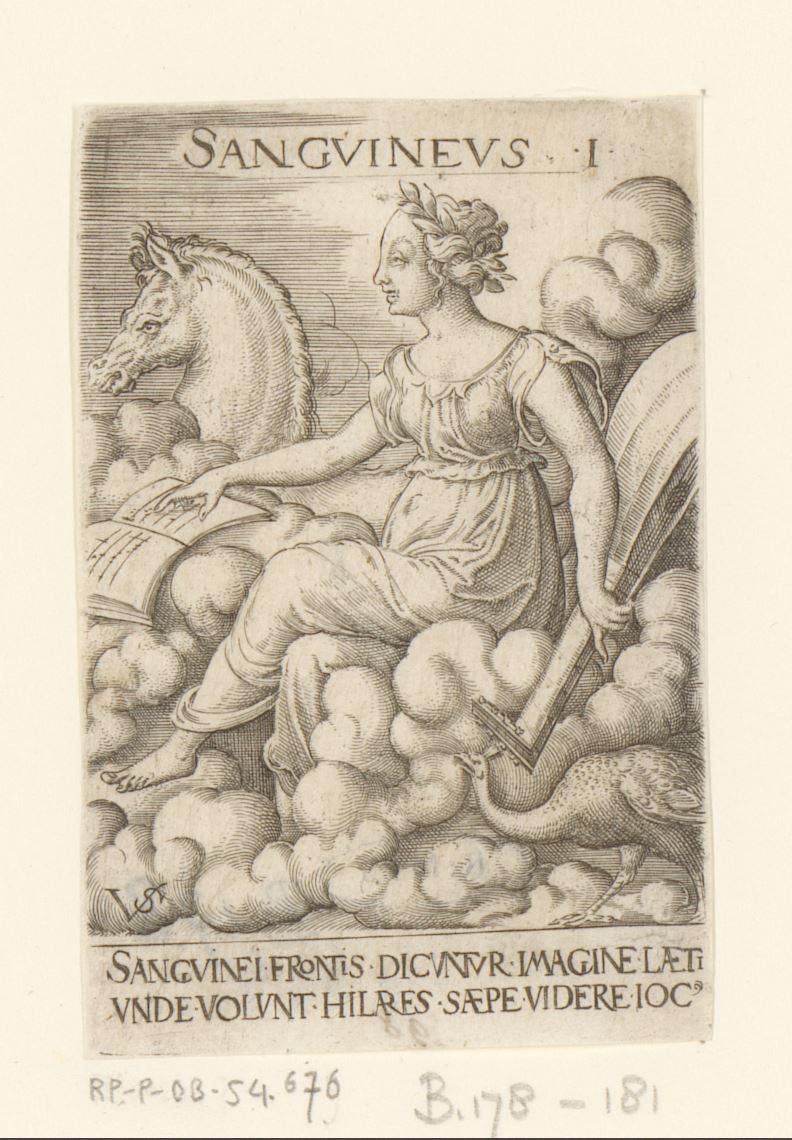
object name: print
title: Sanguinisch temperament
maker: virgilius solis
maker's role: draughtsman, print maker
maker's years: 1514-1562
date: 1524-1562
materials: paper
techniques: engraving, intaglio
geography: nuremberg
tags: sanguine temperament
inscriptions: collector's mark: Lugt 2228, number: ‘98’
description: Maakt deel uit van een serie van vier prenten met personificaties van de temperamenten.